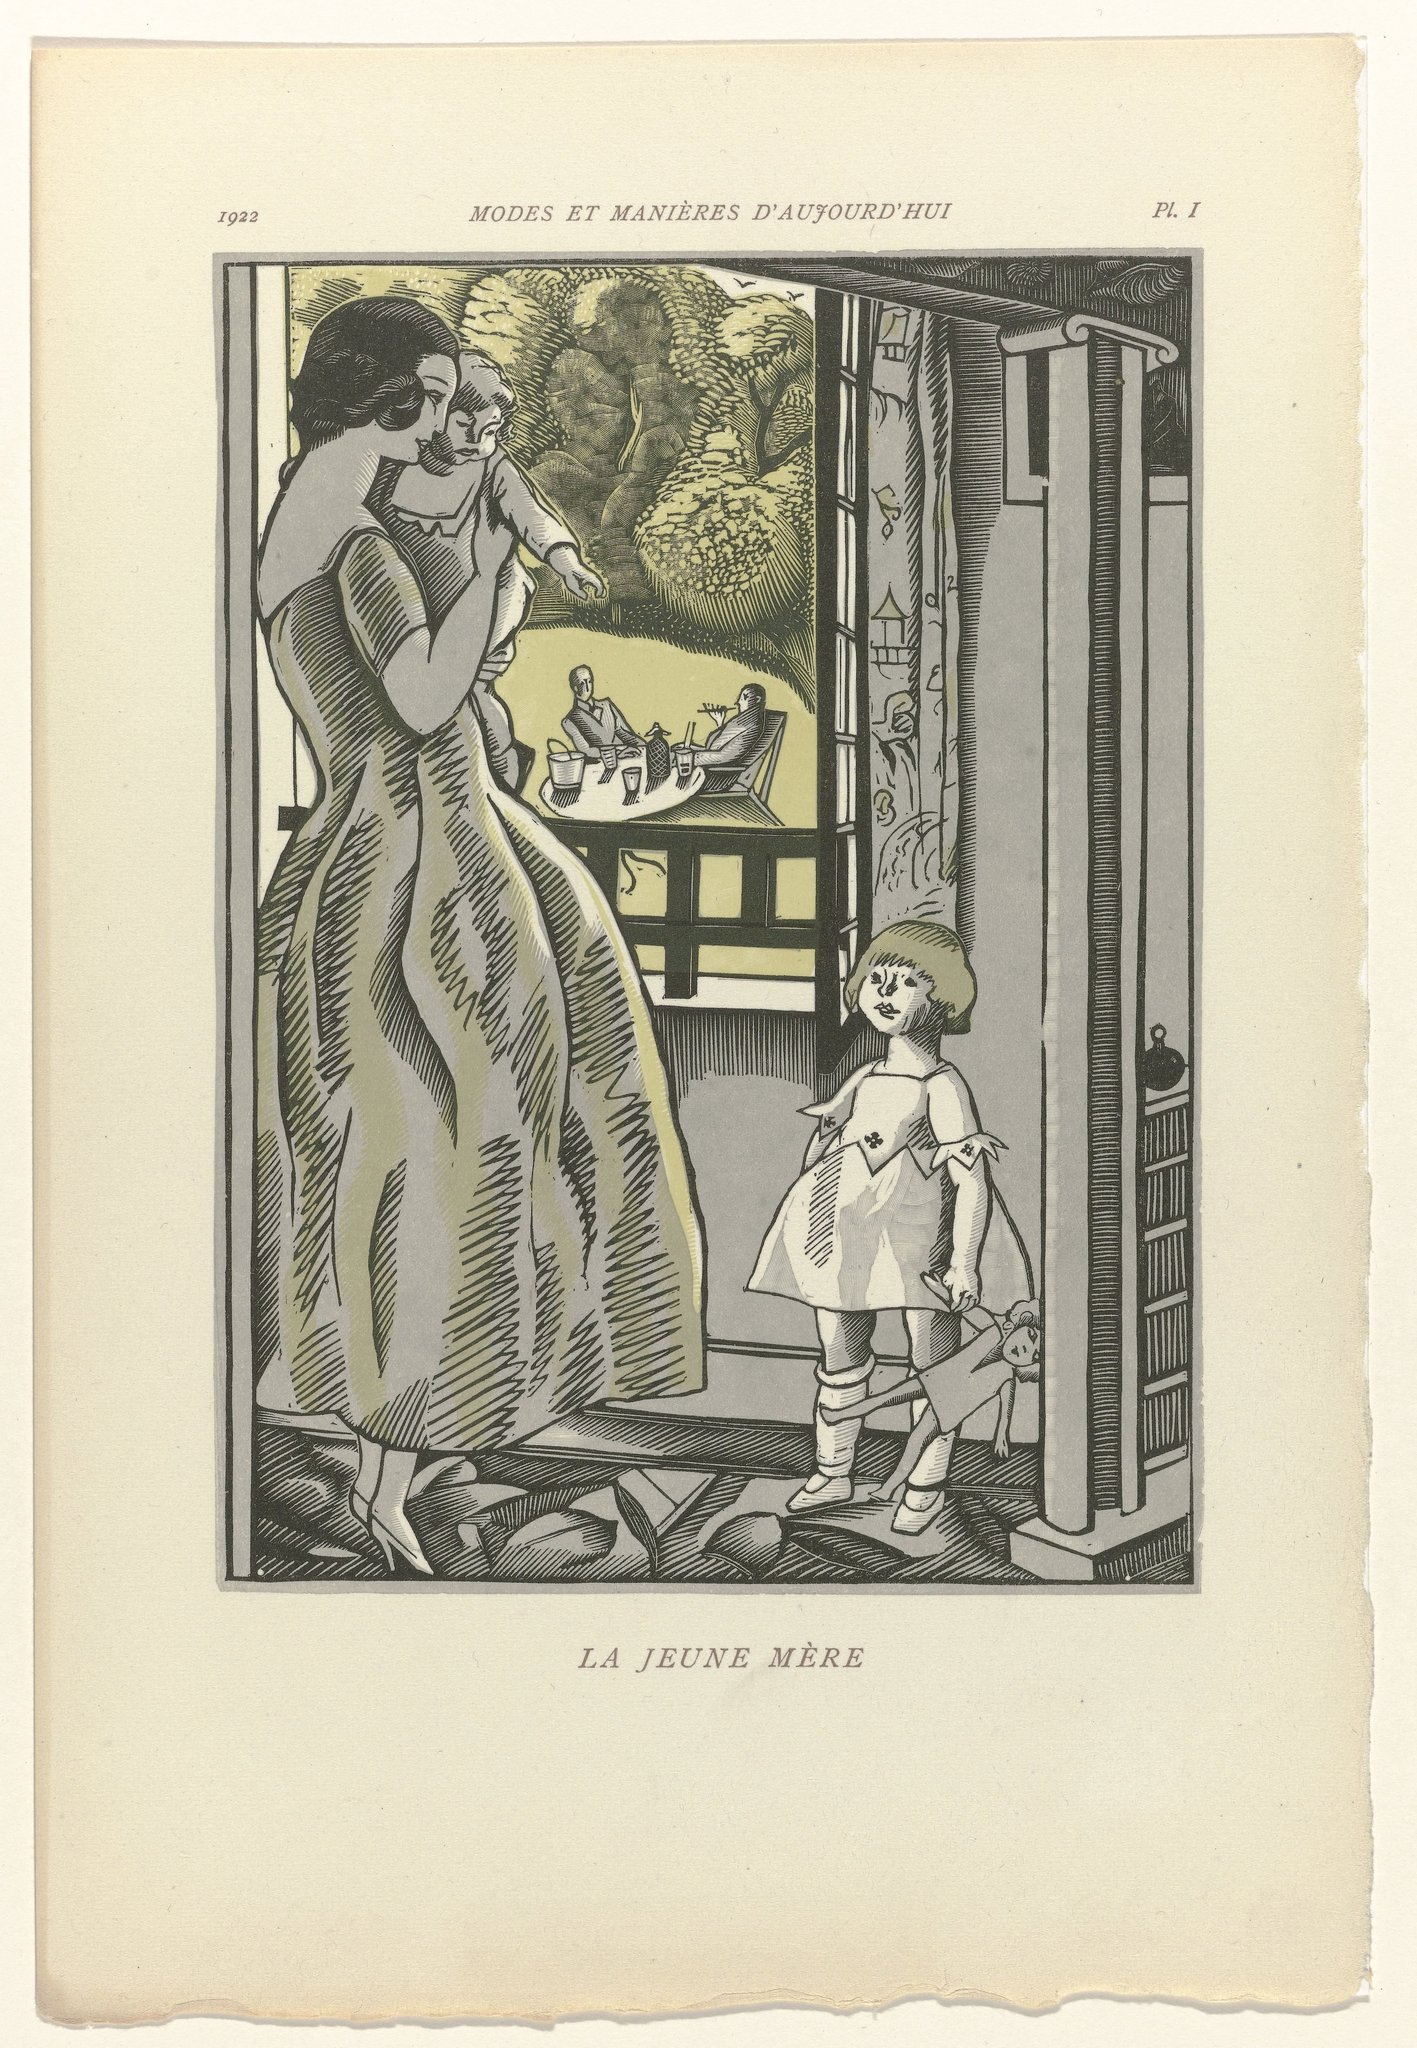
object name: fashion print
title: Modes et Manières d'Aujourd'hui, 1922, Pl. 1 : La jeune mère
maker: Anonymous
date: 1922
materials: paper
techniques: pochoir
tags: other methods of carrying children (+ variant), fashion plates, dress, gown (+ women's clothes), (playing with) dolls, mother and child(ren), woman and child(ren) (family group), human figure at (open) window, seen from inside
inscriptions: title: ‘MODES ET MANIÈRES D'AUJOURD'HUI’, caption: ‘LA JEUNE MÈRE’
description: Een jonge moeder met een kind op de arm, staande voor een open raam. Naast haar een meisje met een pop in de hand. Op de achtergrond twee mannen aan een tafel in een tuin. De prent maakt deel uit van een serie van 12 houtsneden van Fernand Siméon, met teksten van Paul Valery, voor het zevende deel (10e année 1922) van Modes et Manières d'Aujourd'hui. Elke uitgave had een oplage van slechts 300 stuks en was exclusief gewijd aan één kunstenaar die 12 prenten ontwierp rond een bepaald thema. In deze serie staat het 'leven van de modieuze vrouw in de maatschappij' centraal.